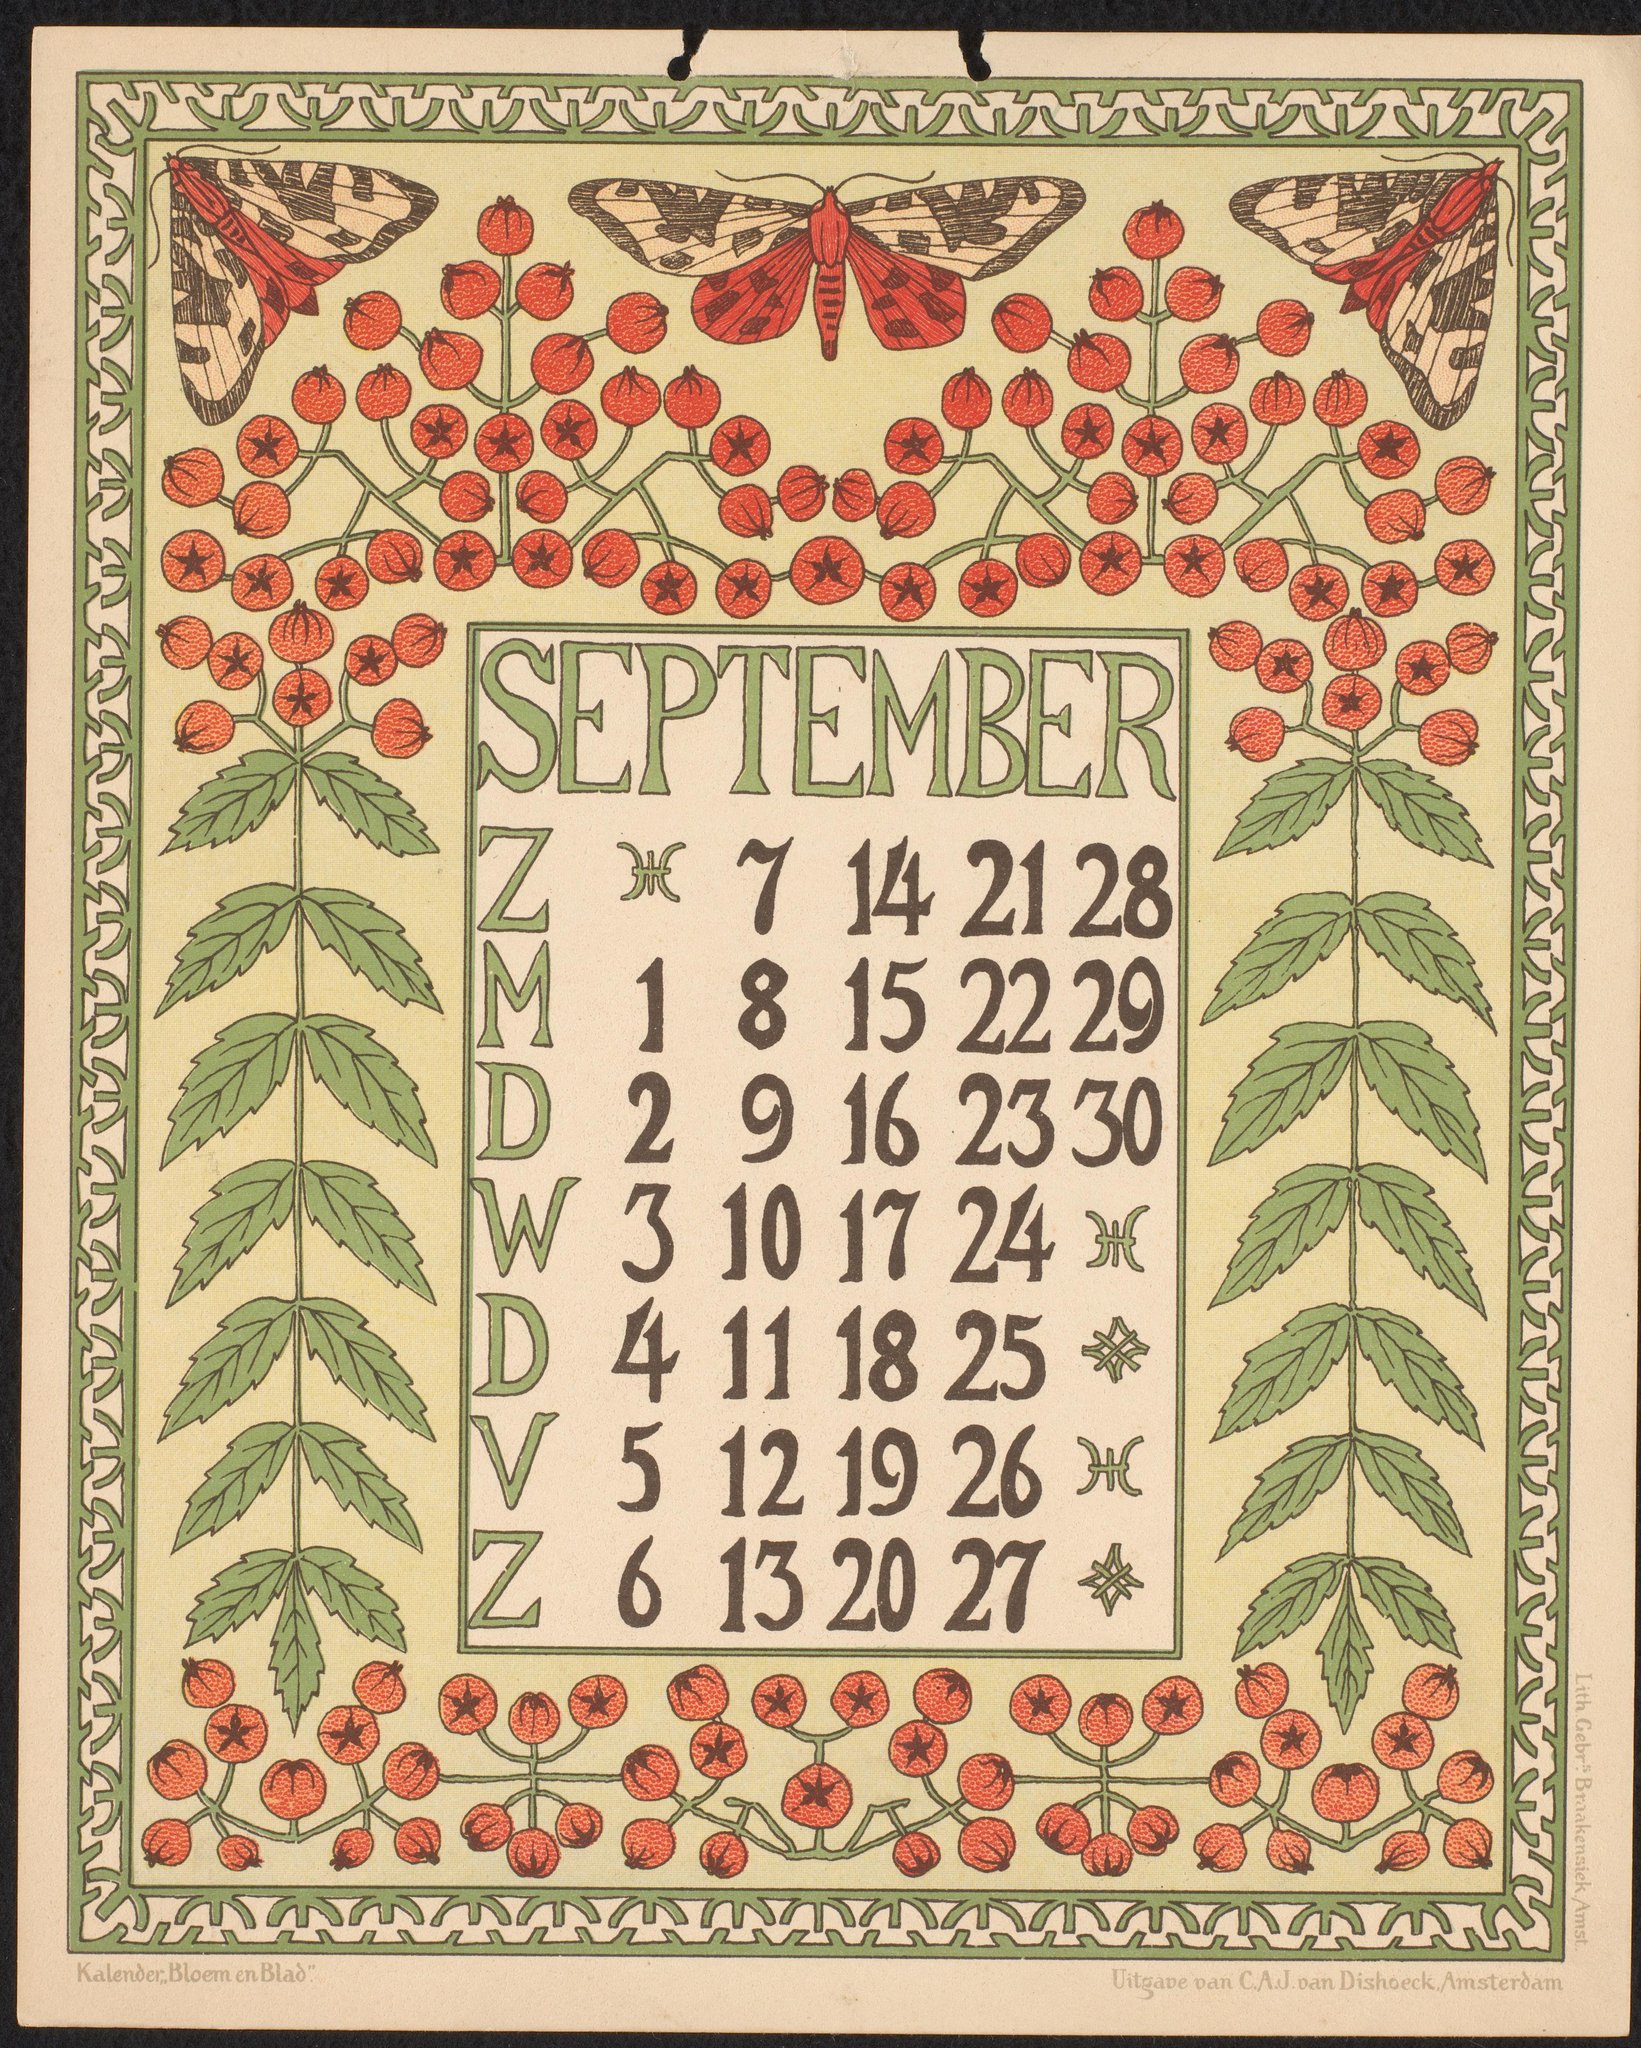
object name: calendar leaf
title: Kalenderblad voor september 1902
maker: c.a.j. van dishoeck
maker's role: publisher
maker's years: 1863-1931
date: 1901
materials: paper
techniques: lithograph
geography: amsterdam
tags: flowers, ornaments ~ art, calendar, almanac, insects: butterfly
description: Kalenderblad voor september 1902 van de kalender 'Bloem en Blad', met een randdecoratie van bessen en vlinders.